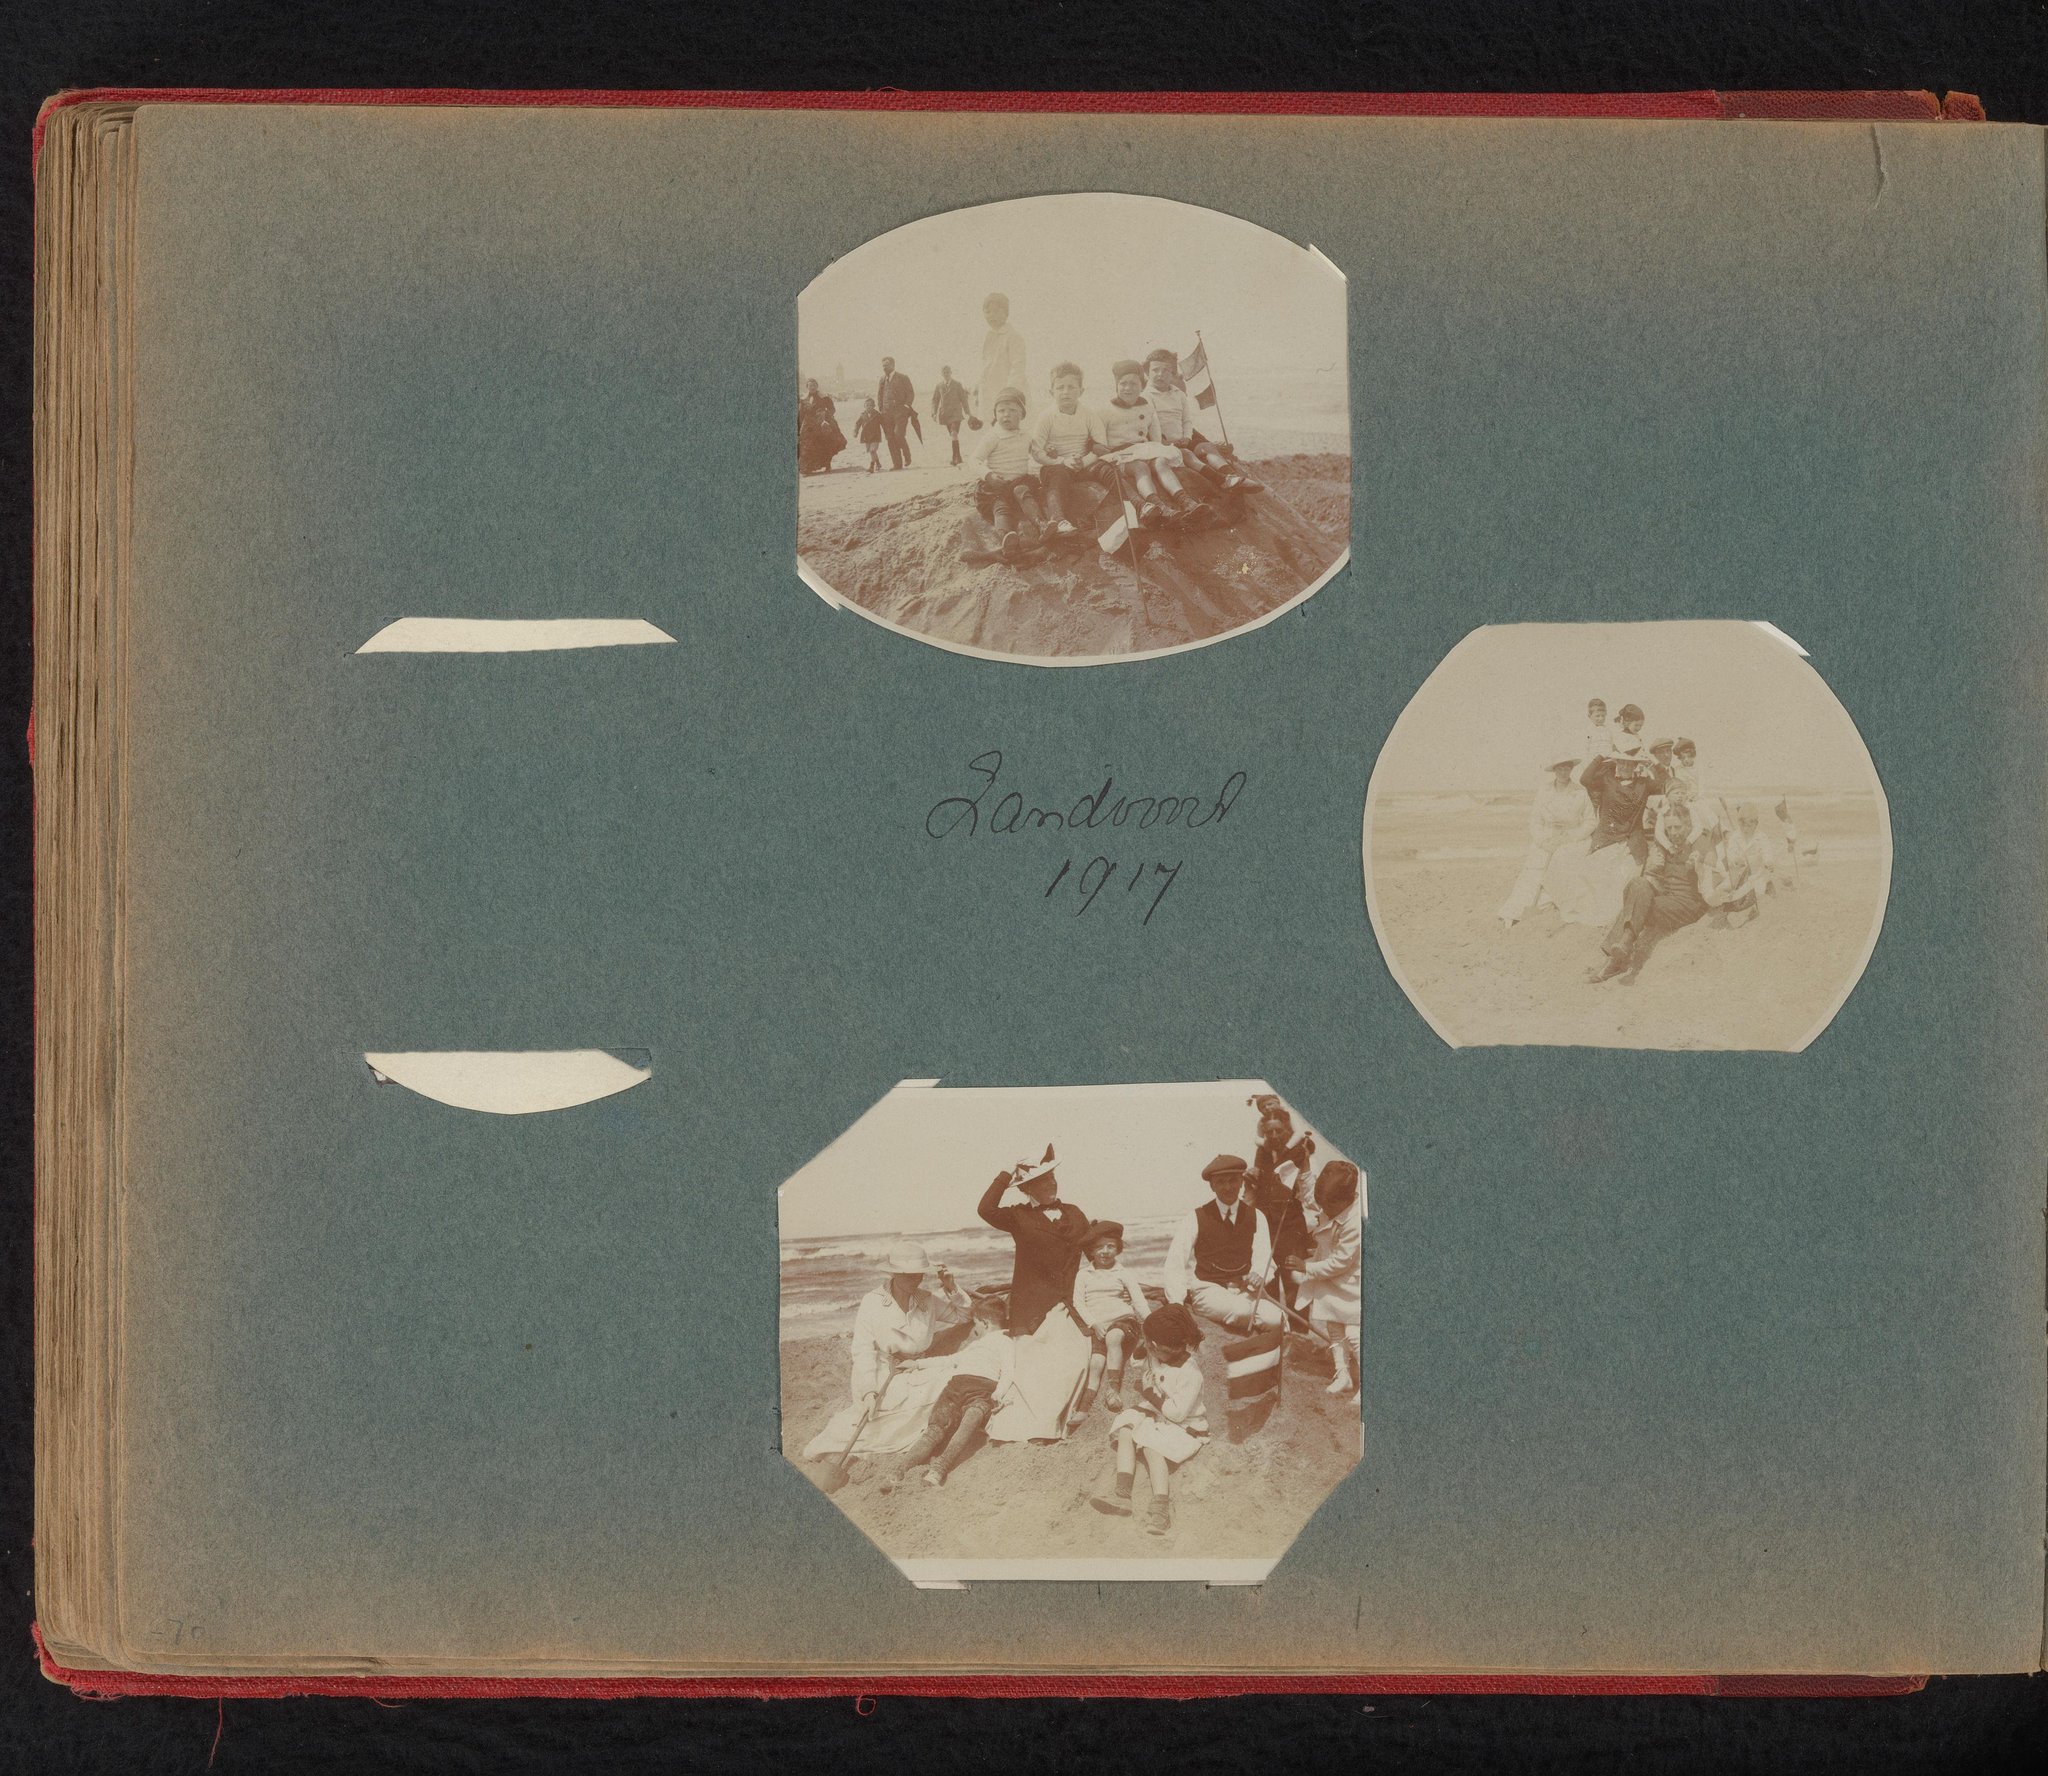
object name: album leaf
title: Zandvoort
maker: charlotte alida boelen-matthes (lot)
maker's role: amateurfotograaf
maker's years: 1889-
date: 1917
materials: paper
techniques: gelatin silver print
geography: zandvoort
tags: amsterdam, eva charlotte pennink-boelen, beach (as place of recreation), child and nature (games and plays)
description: Deze foto's zijn onderdeel van een album.